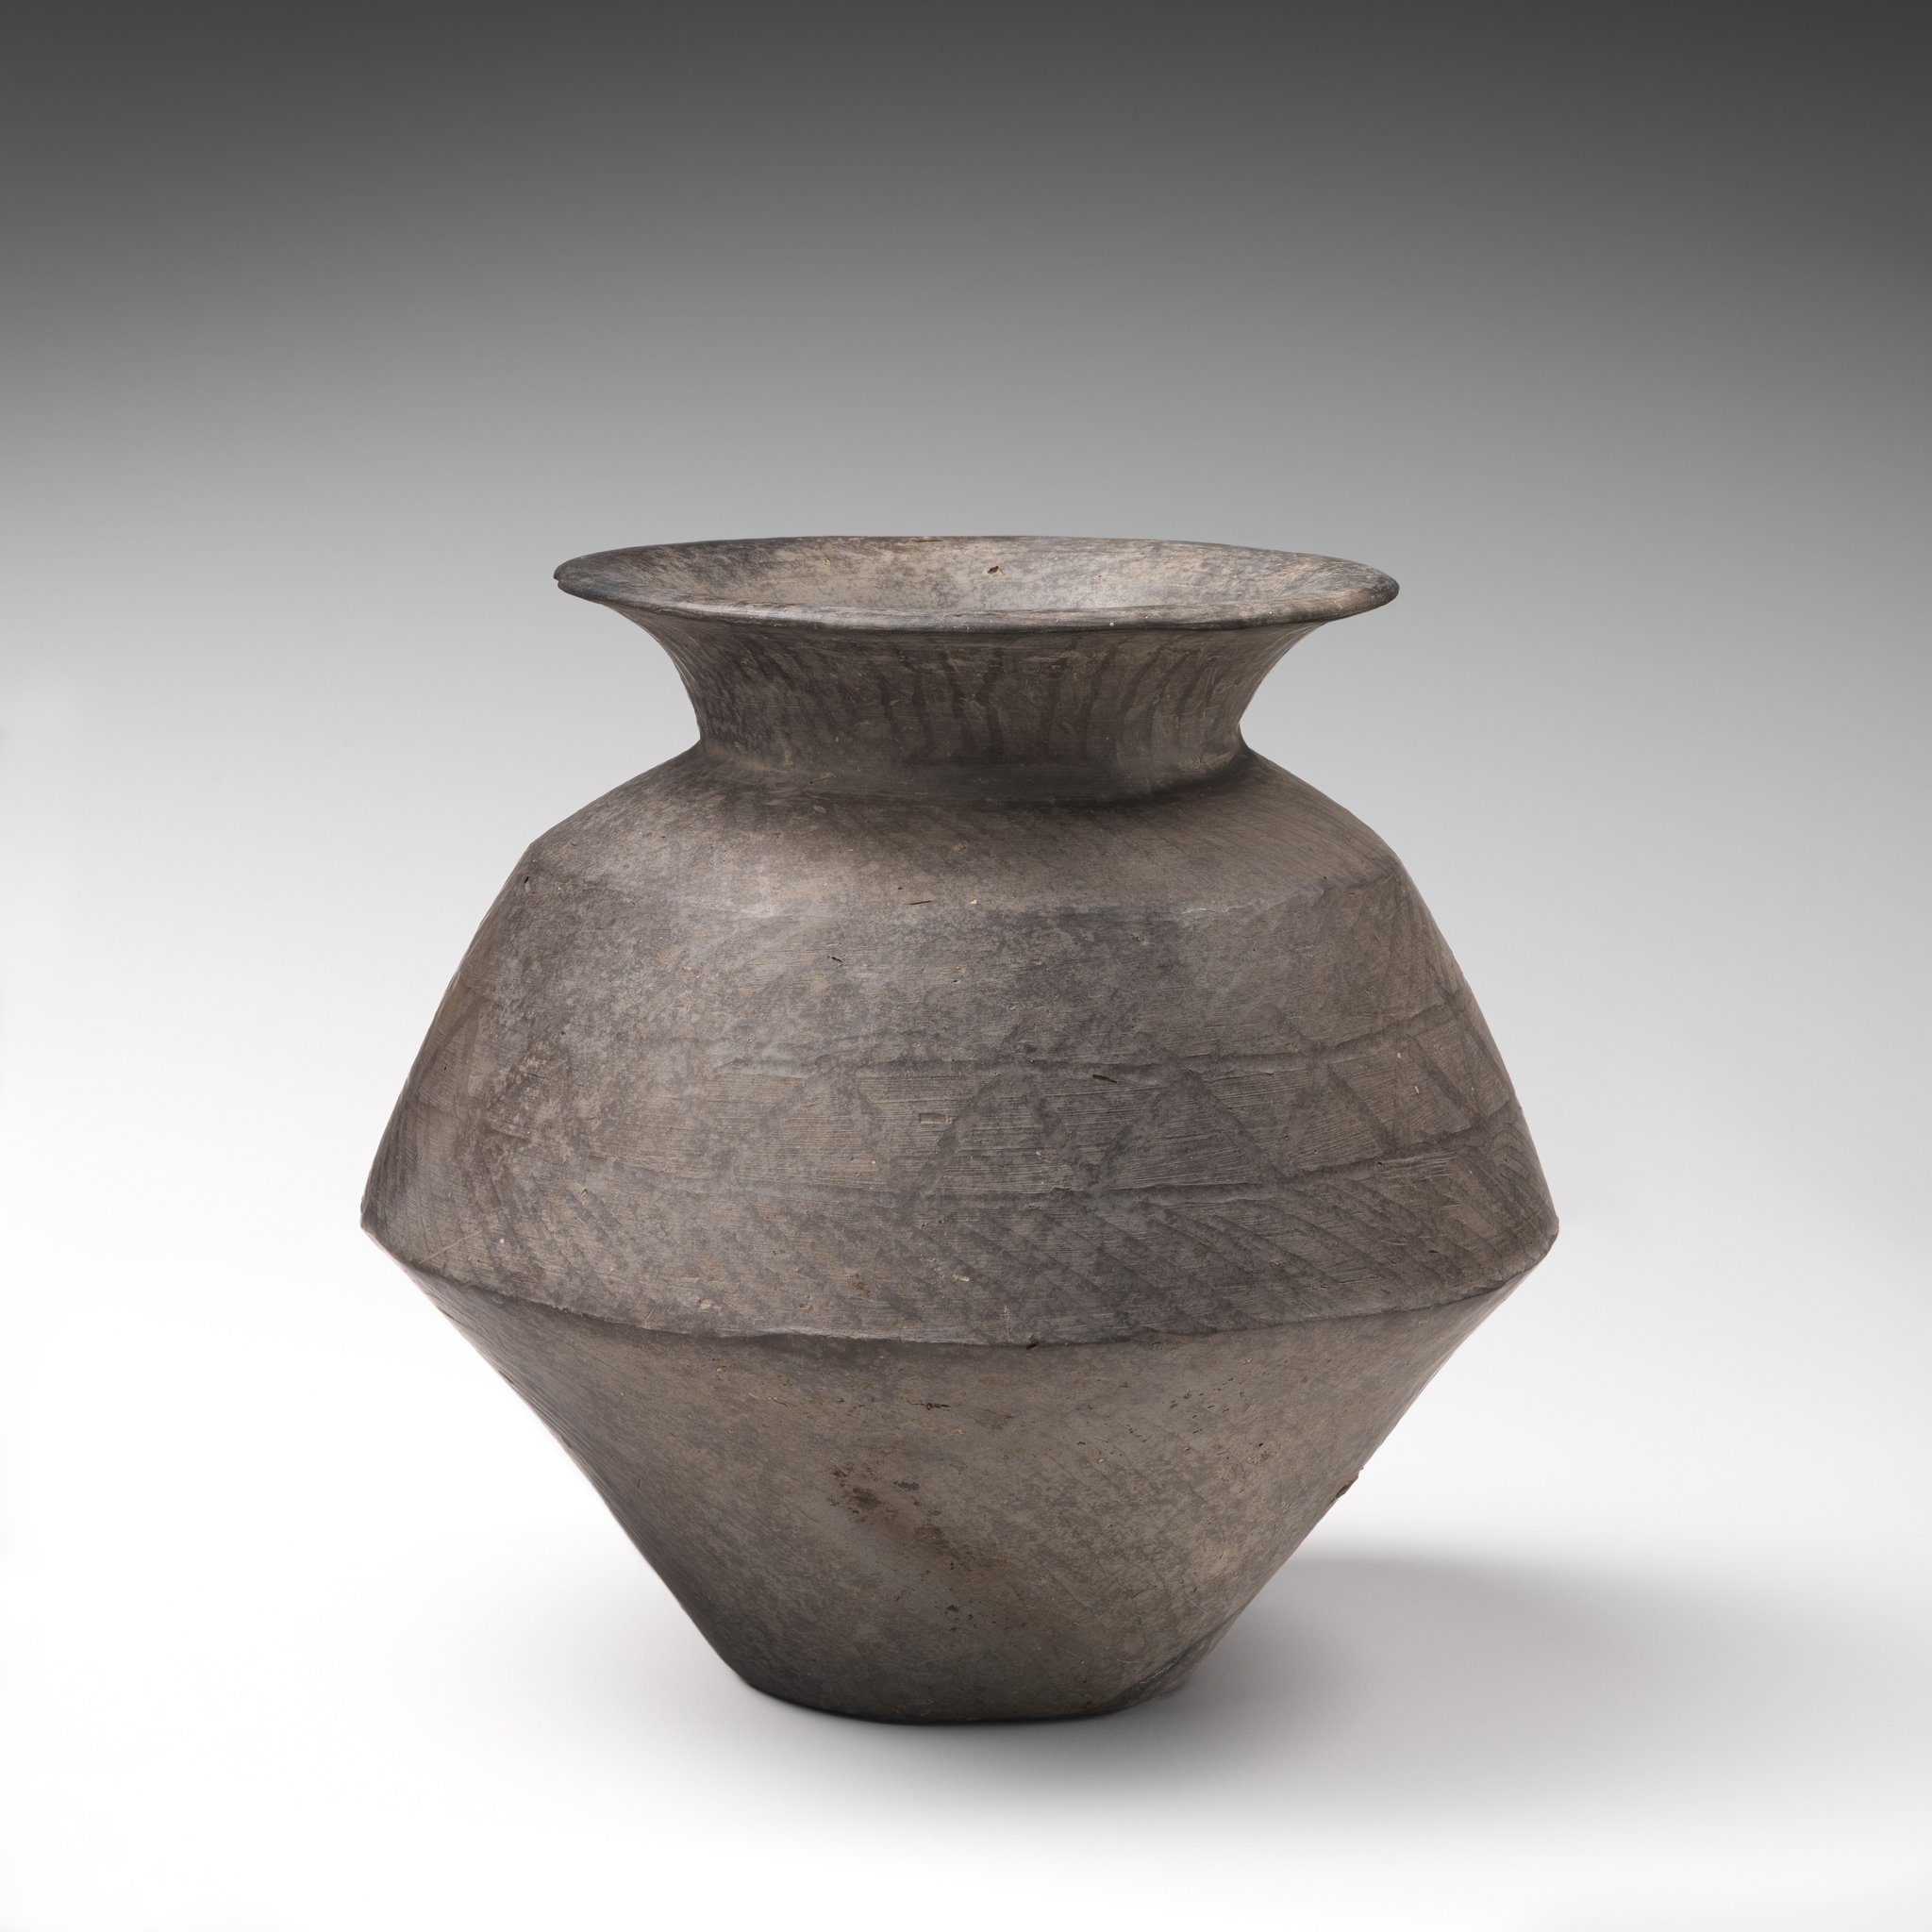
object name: vessel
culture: iranian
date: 3000-2250 BCE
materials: ceramic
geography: iran